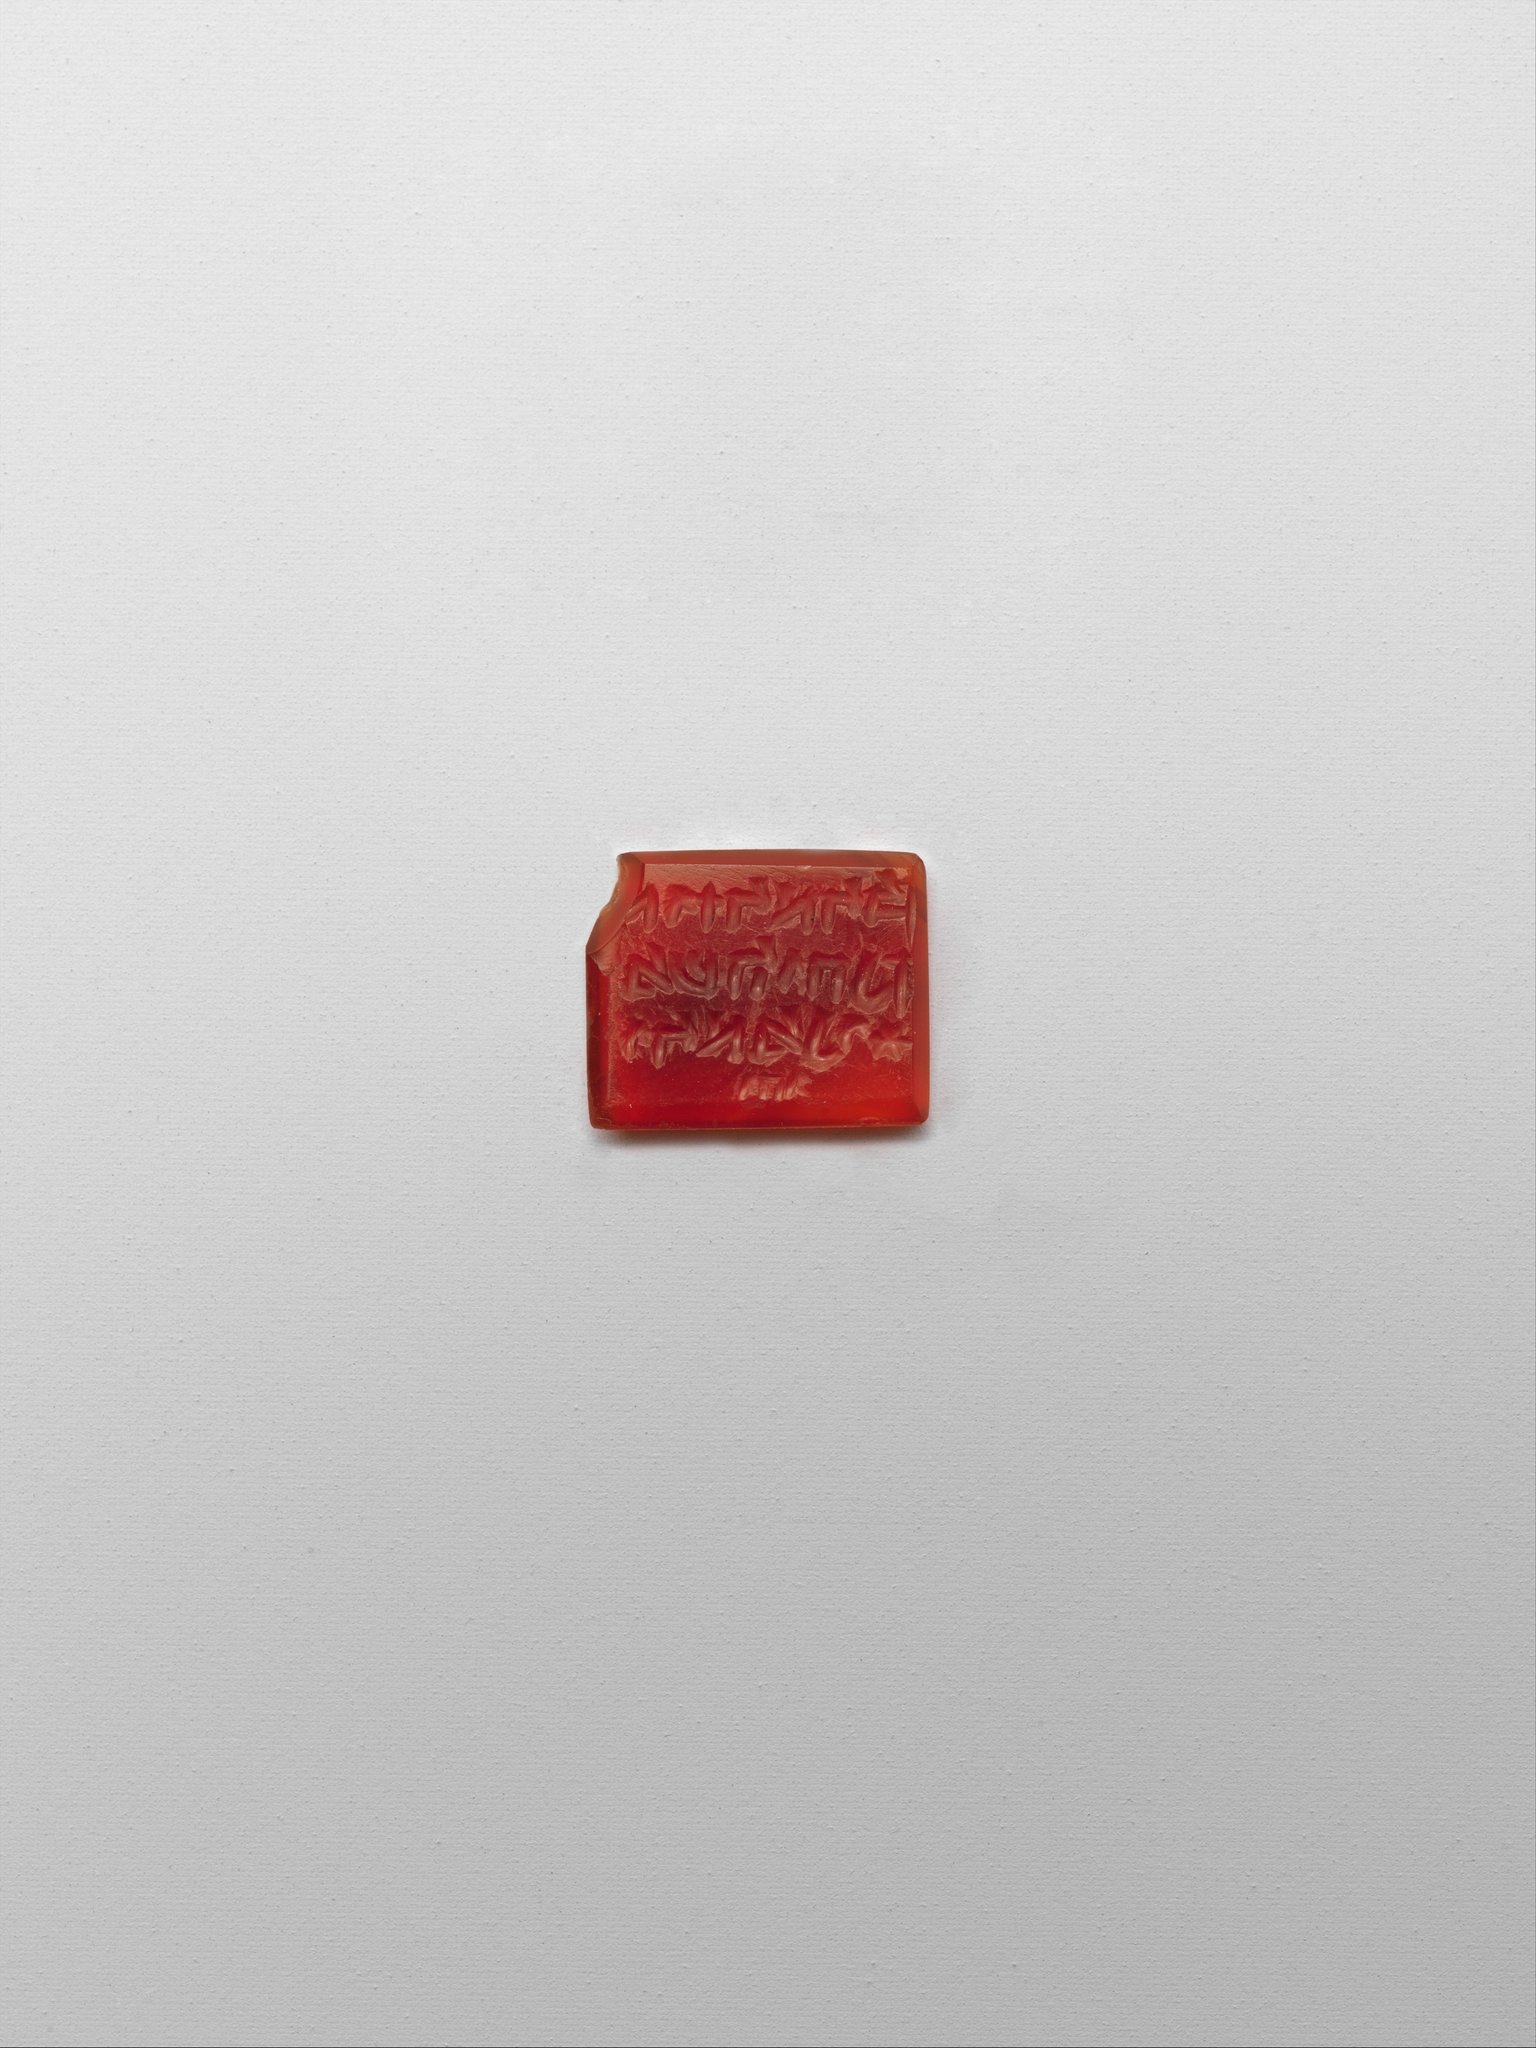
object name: seal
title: Seal with Hebrew Inscription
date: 901-1100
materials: gemstone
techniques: incising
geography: iran